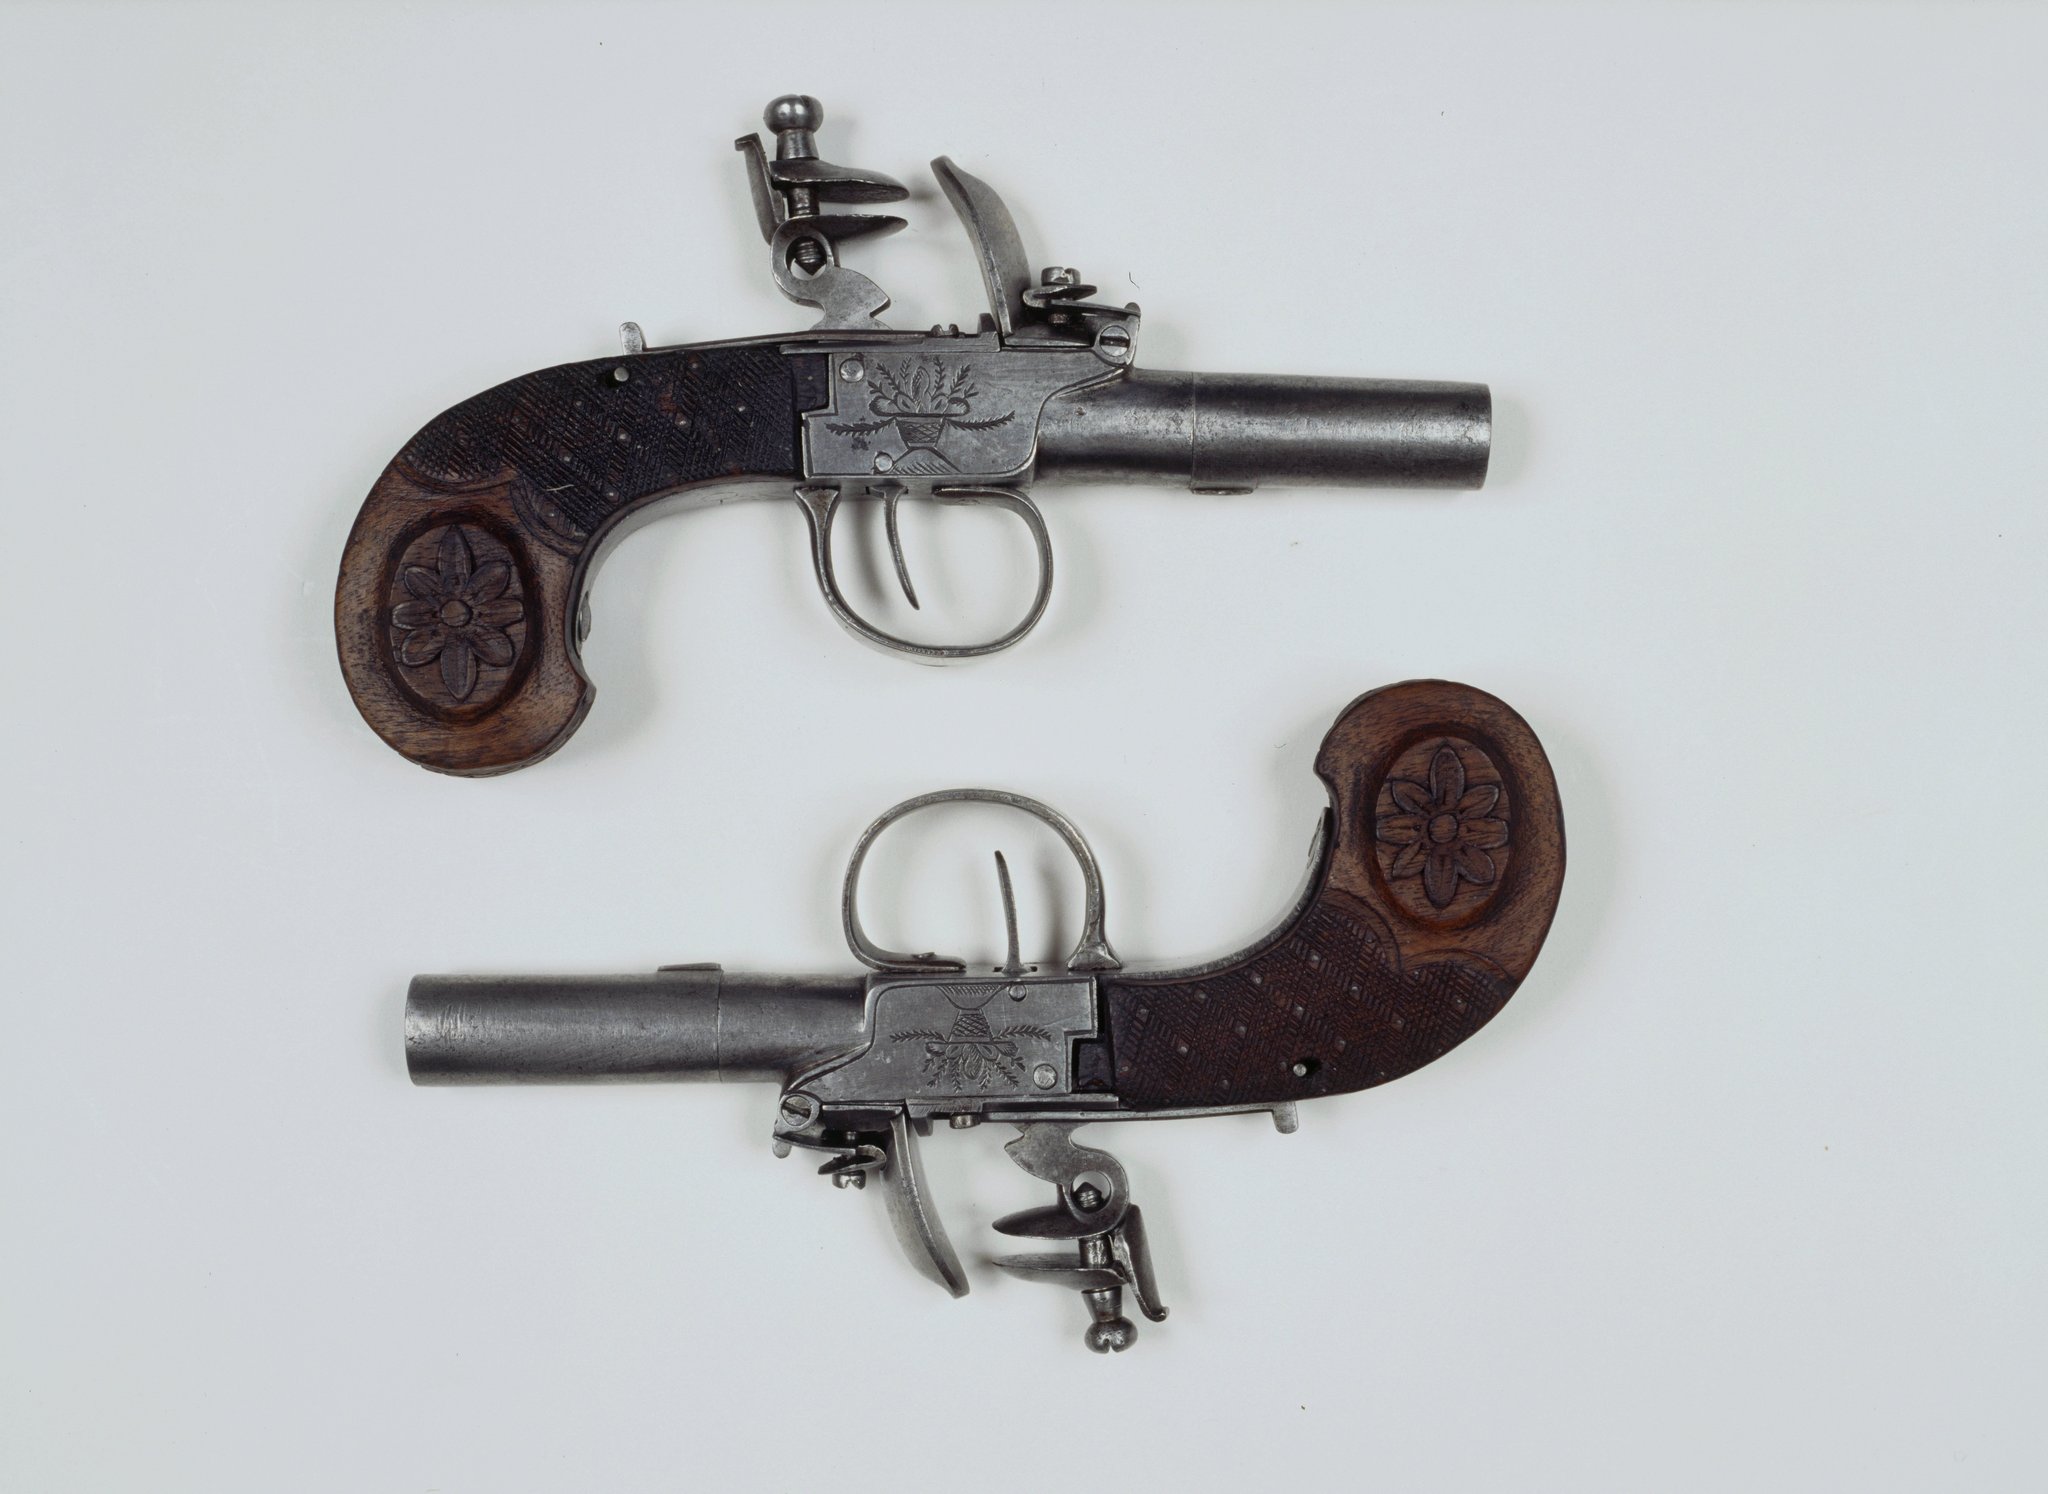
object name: flintlock pistol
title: Zakpistool met vuursteenslot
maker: Anonymous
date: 1800-1850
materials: iron, silver, wood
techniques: inlay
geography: scotland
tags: netherlands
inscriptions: mark: ‘E // LG’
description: Zakpistool met vuursteenslot, deel van koppel. Ronde gladde loop, afschroefbaar. IJzeren beslag. Gegraveerd op slotkast. Loop gemerkt LEG. Schots model.